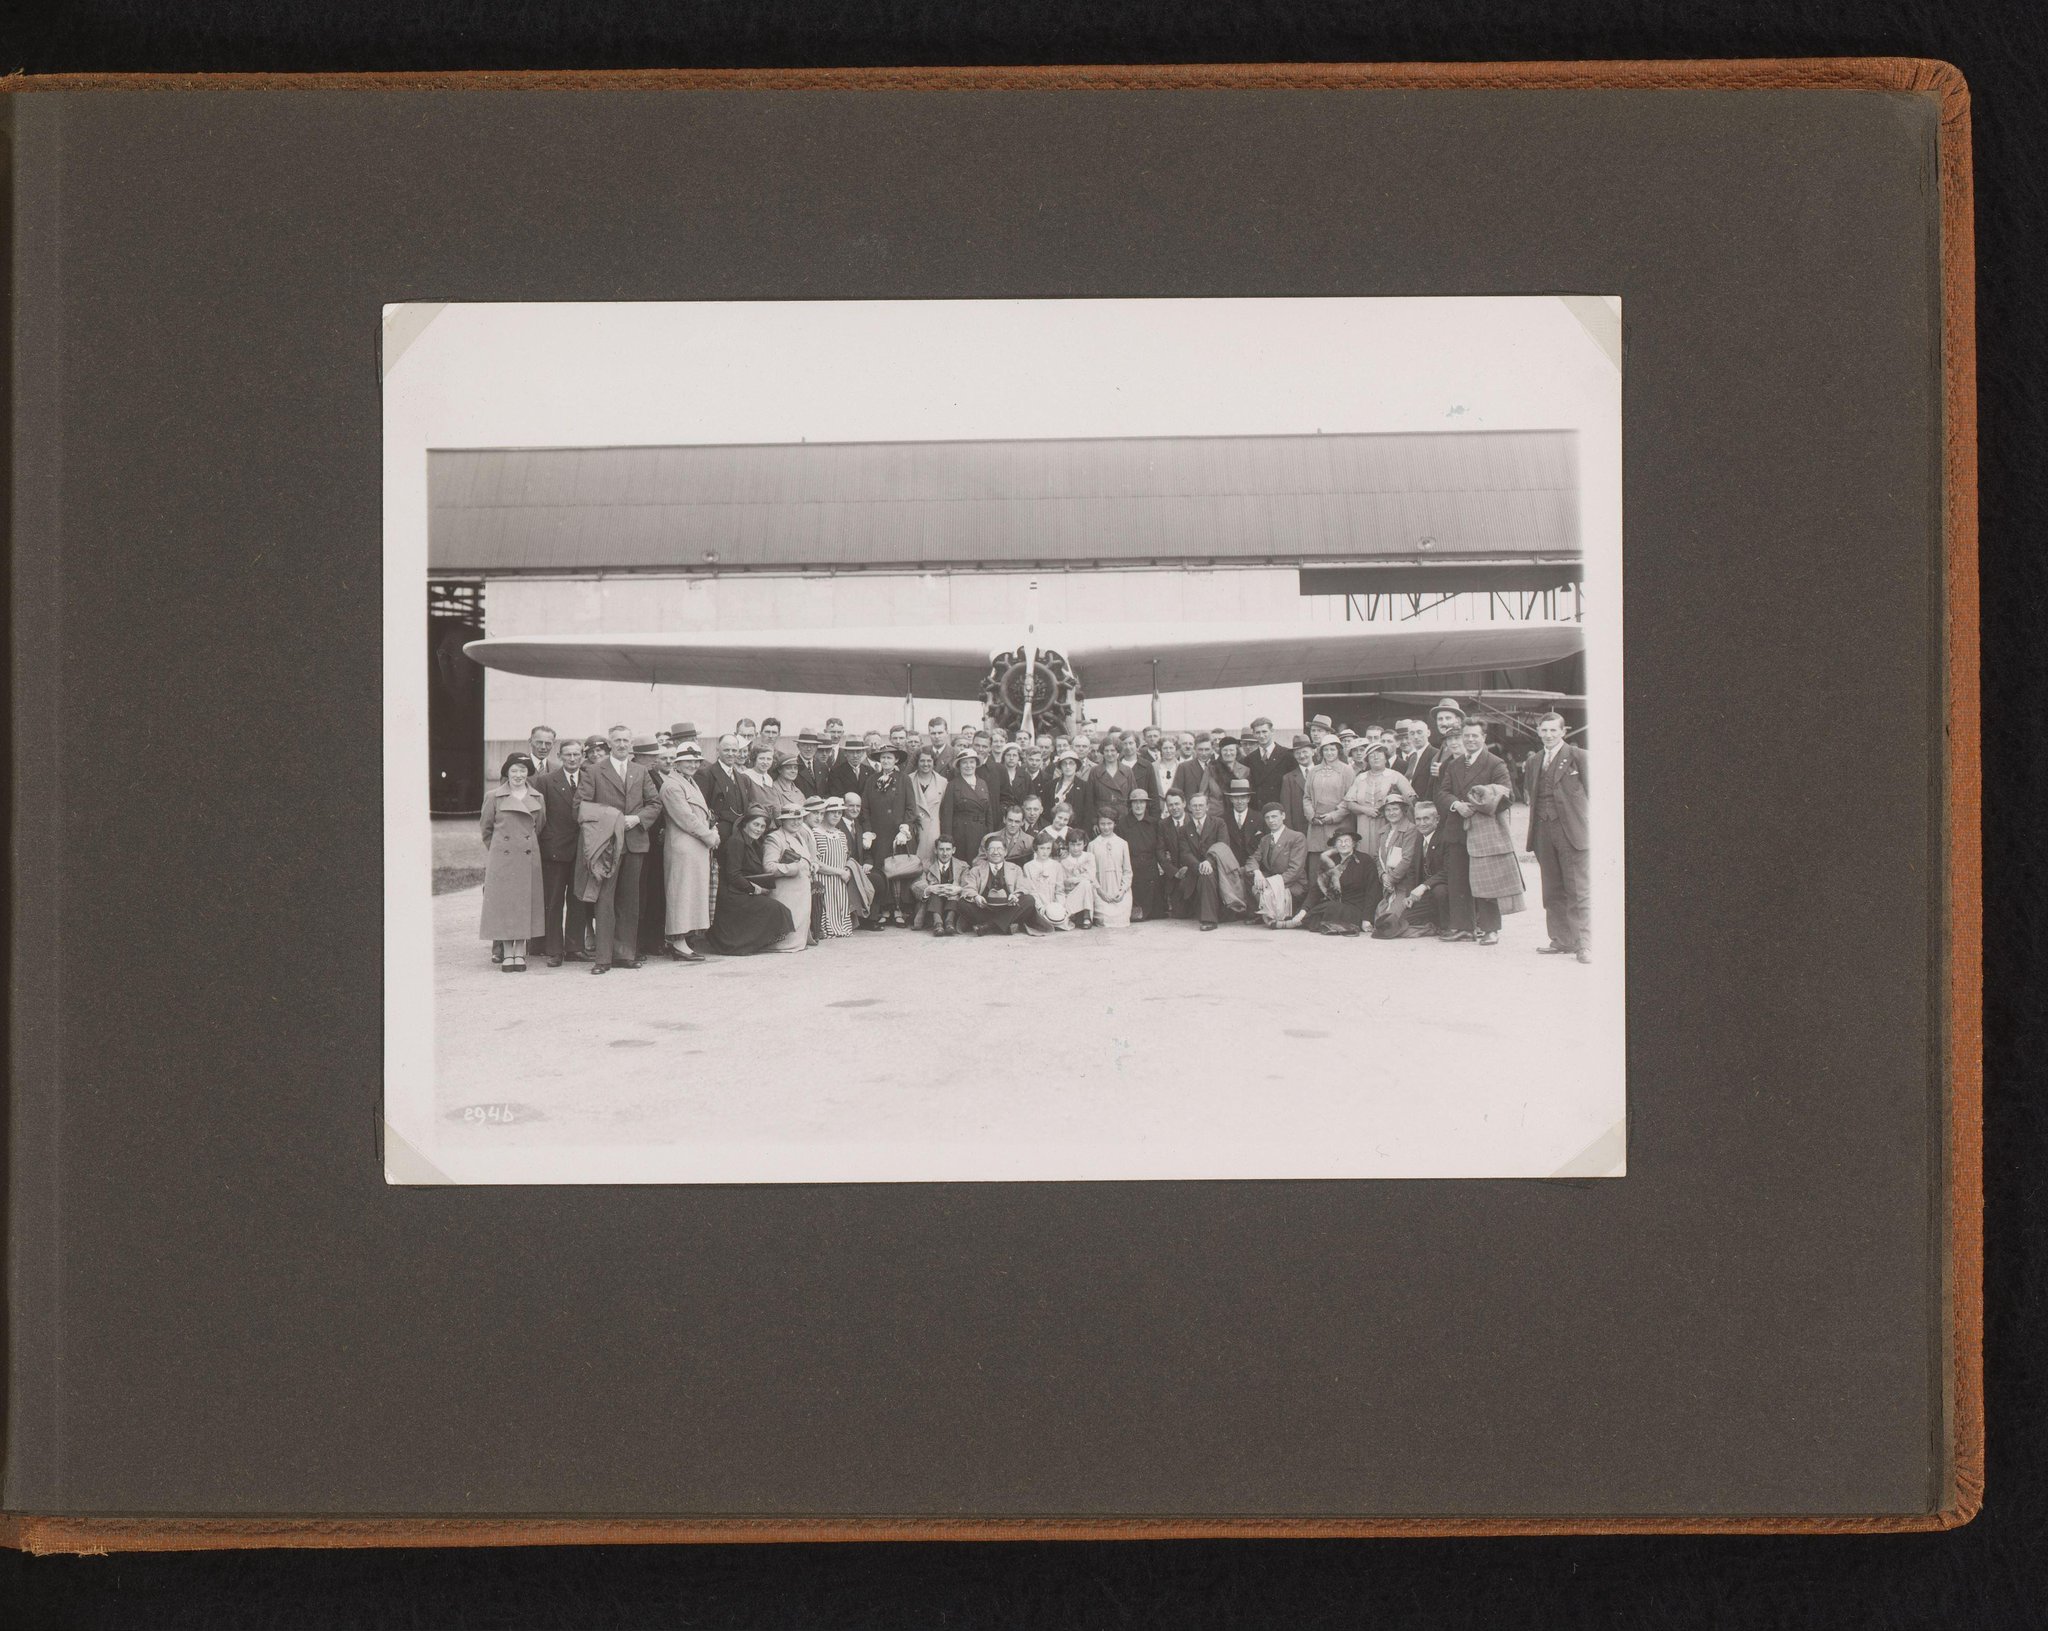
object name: album leaf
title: Groepsfoto op het vliegveld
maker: Anonymous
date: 1935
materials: paper, photographic support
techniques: gelatin silver print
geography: rotterdam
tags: aircraft, aeroplane, airfield, airport, esperanto, anonymous historical persons portrayed in a group, in a group-portrait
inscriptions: inscription: ‘Rotterdam, Zondag 8 Sept. '35’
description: Albumblad met een groepsfoto van een grote groep mensen poserend voor een vliegtuig op het vliegveld Zestienhoven te Rotterdam, 1935. Waarschijnlijk de Esperanto vereniging. Onderdeel van het Esperanto album uit ca. 1933-1936.